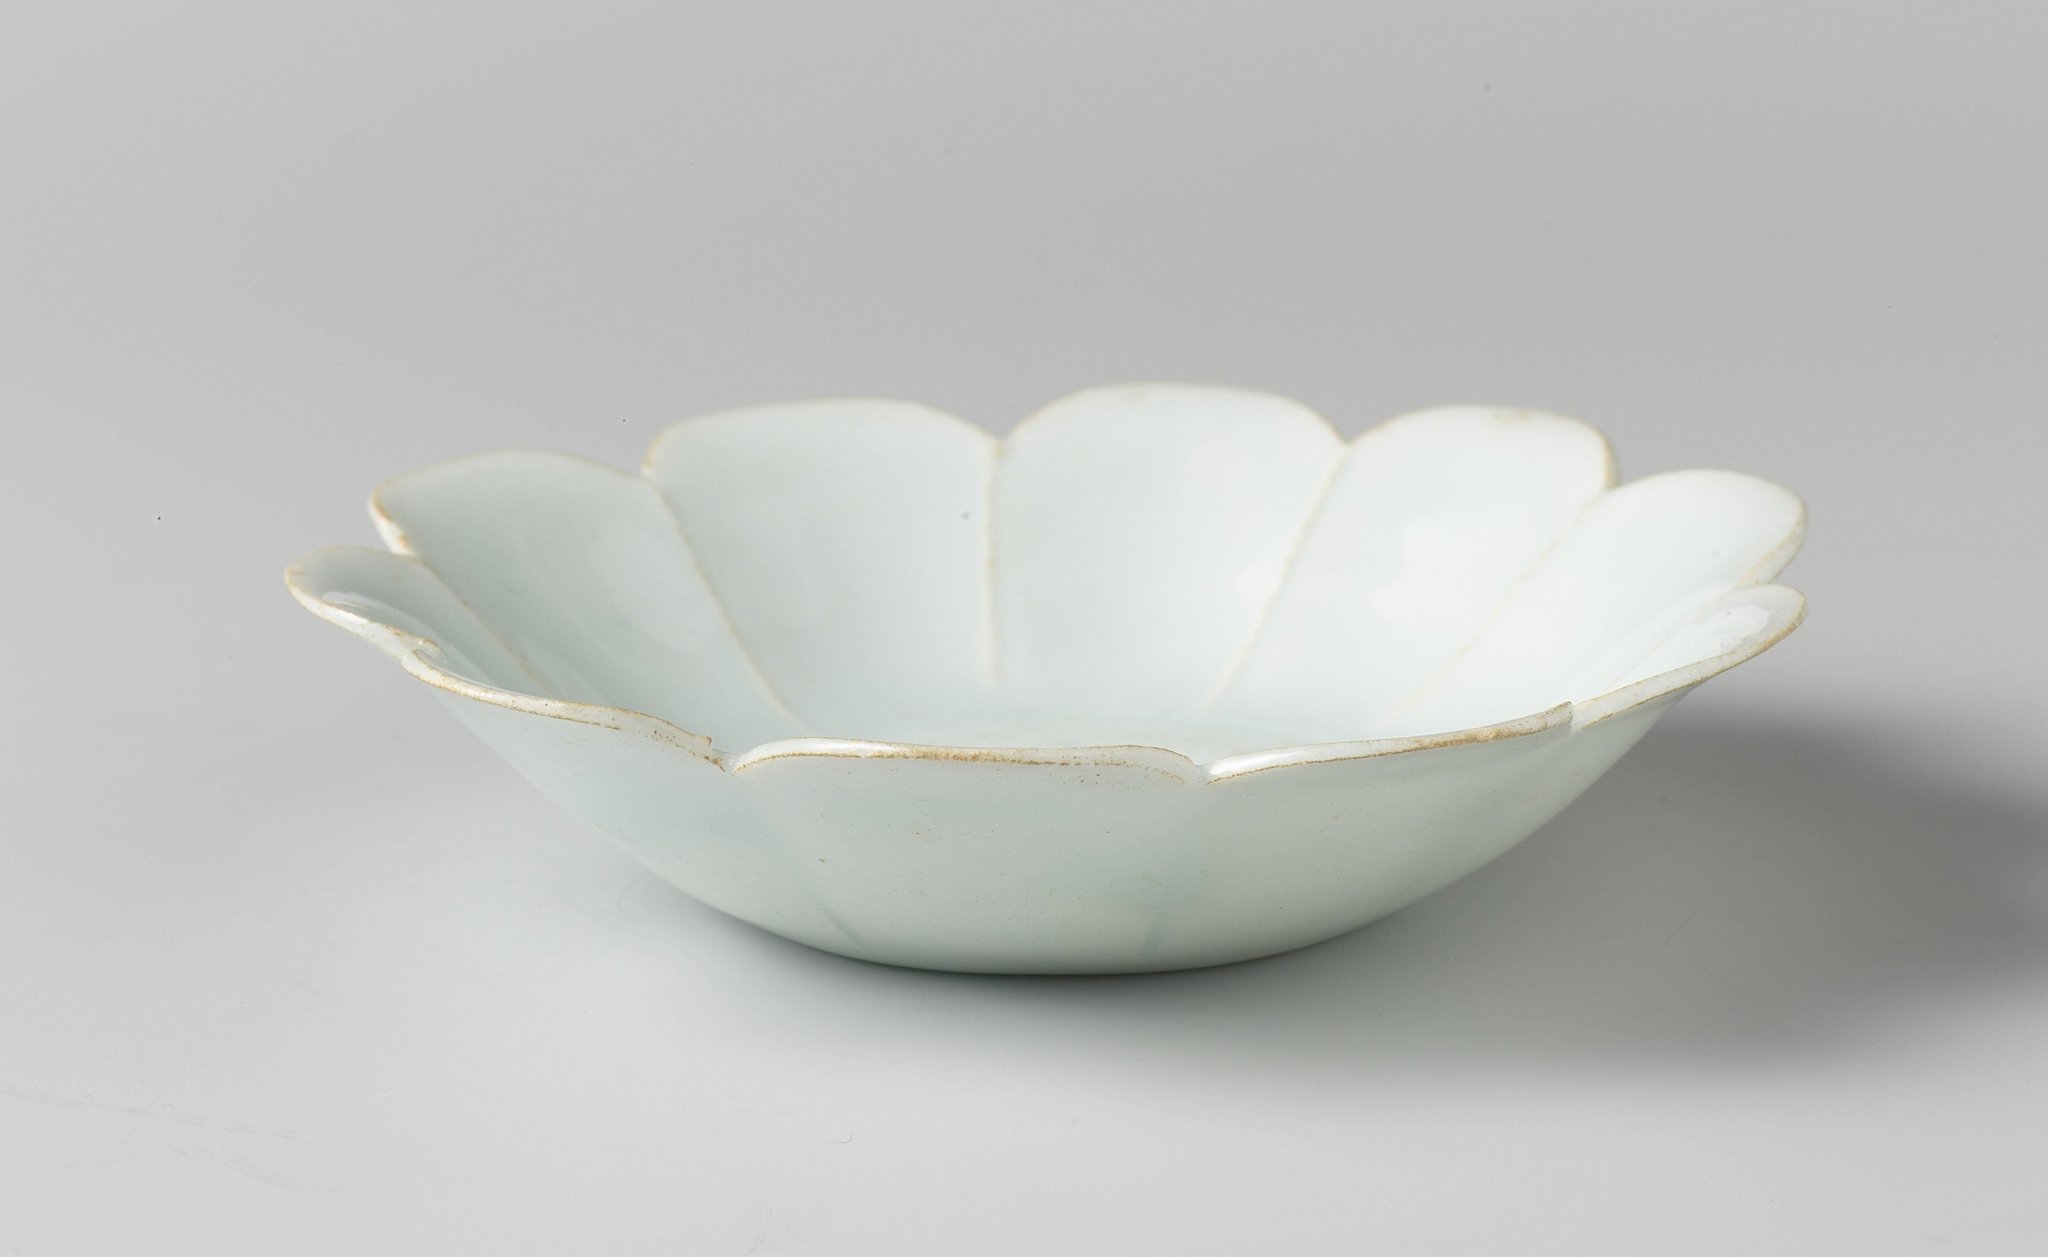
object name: dish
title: Saucer-dish in the shape of a flower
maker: Anonymous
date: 1100-1199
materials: glaze, stoneware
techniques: firing, forming, turning, vitrification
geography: china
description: Schaal van steengoed in de vorm van een bloem, bedekt met een transparant glazuur met een lichtblauwe tint. De wand is gemodelleerd in tien bloembladeren, op de binnenwand gescheiden door ribben. Een barst in de wand. Qingbai.